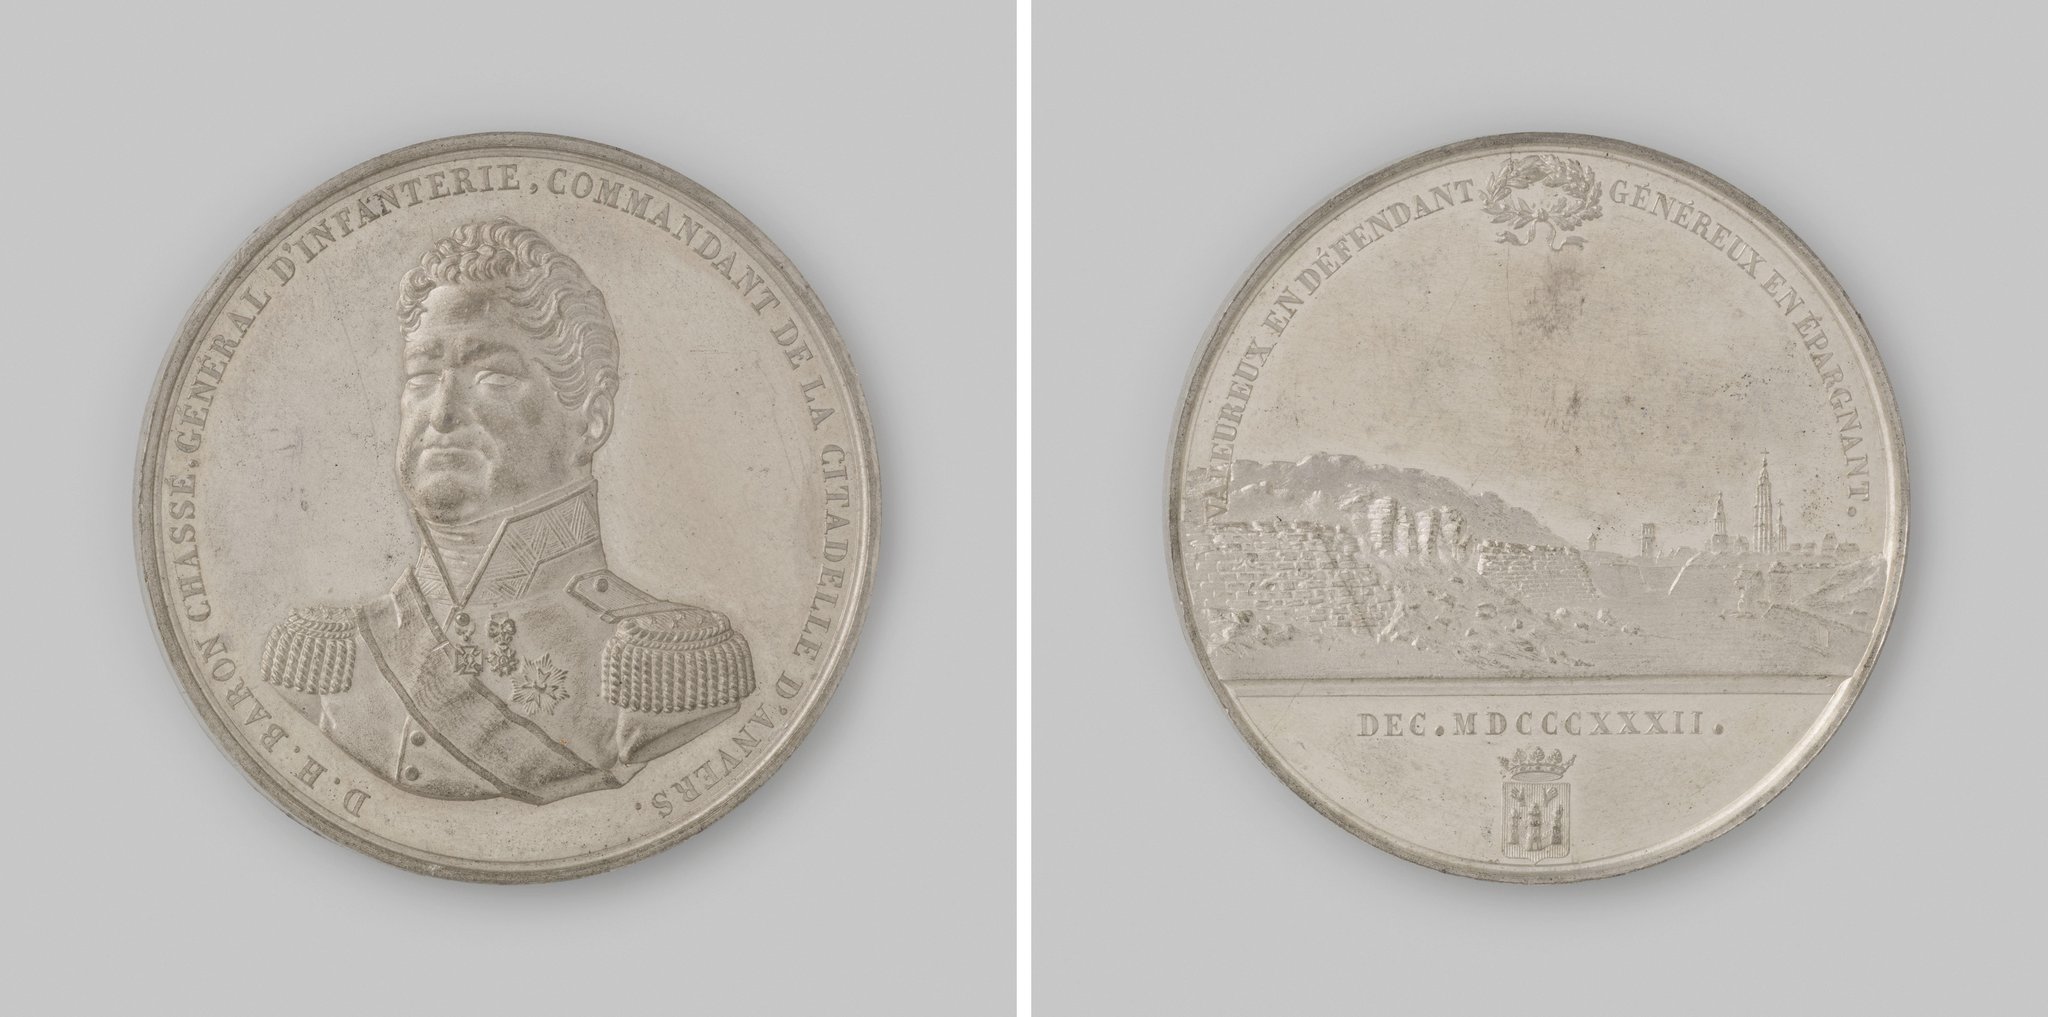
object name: history medal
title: Generaal Chassé spaart de stad Antwerpen 1832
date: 1832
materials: tin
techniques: striking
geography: antwerp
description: Tinnen penning, op de voorzijde het borstbeeld van Chassé half naar links met omschrift, op de keerzijde de beschadigde Citadel van Antwerpen met een omschrift waarbinnen een kleine lauwerkrans en in afsnede een tekst boven een gekroond Antwerpens wapenschildje.